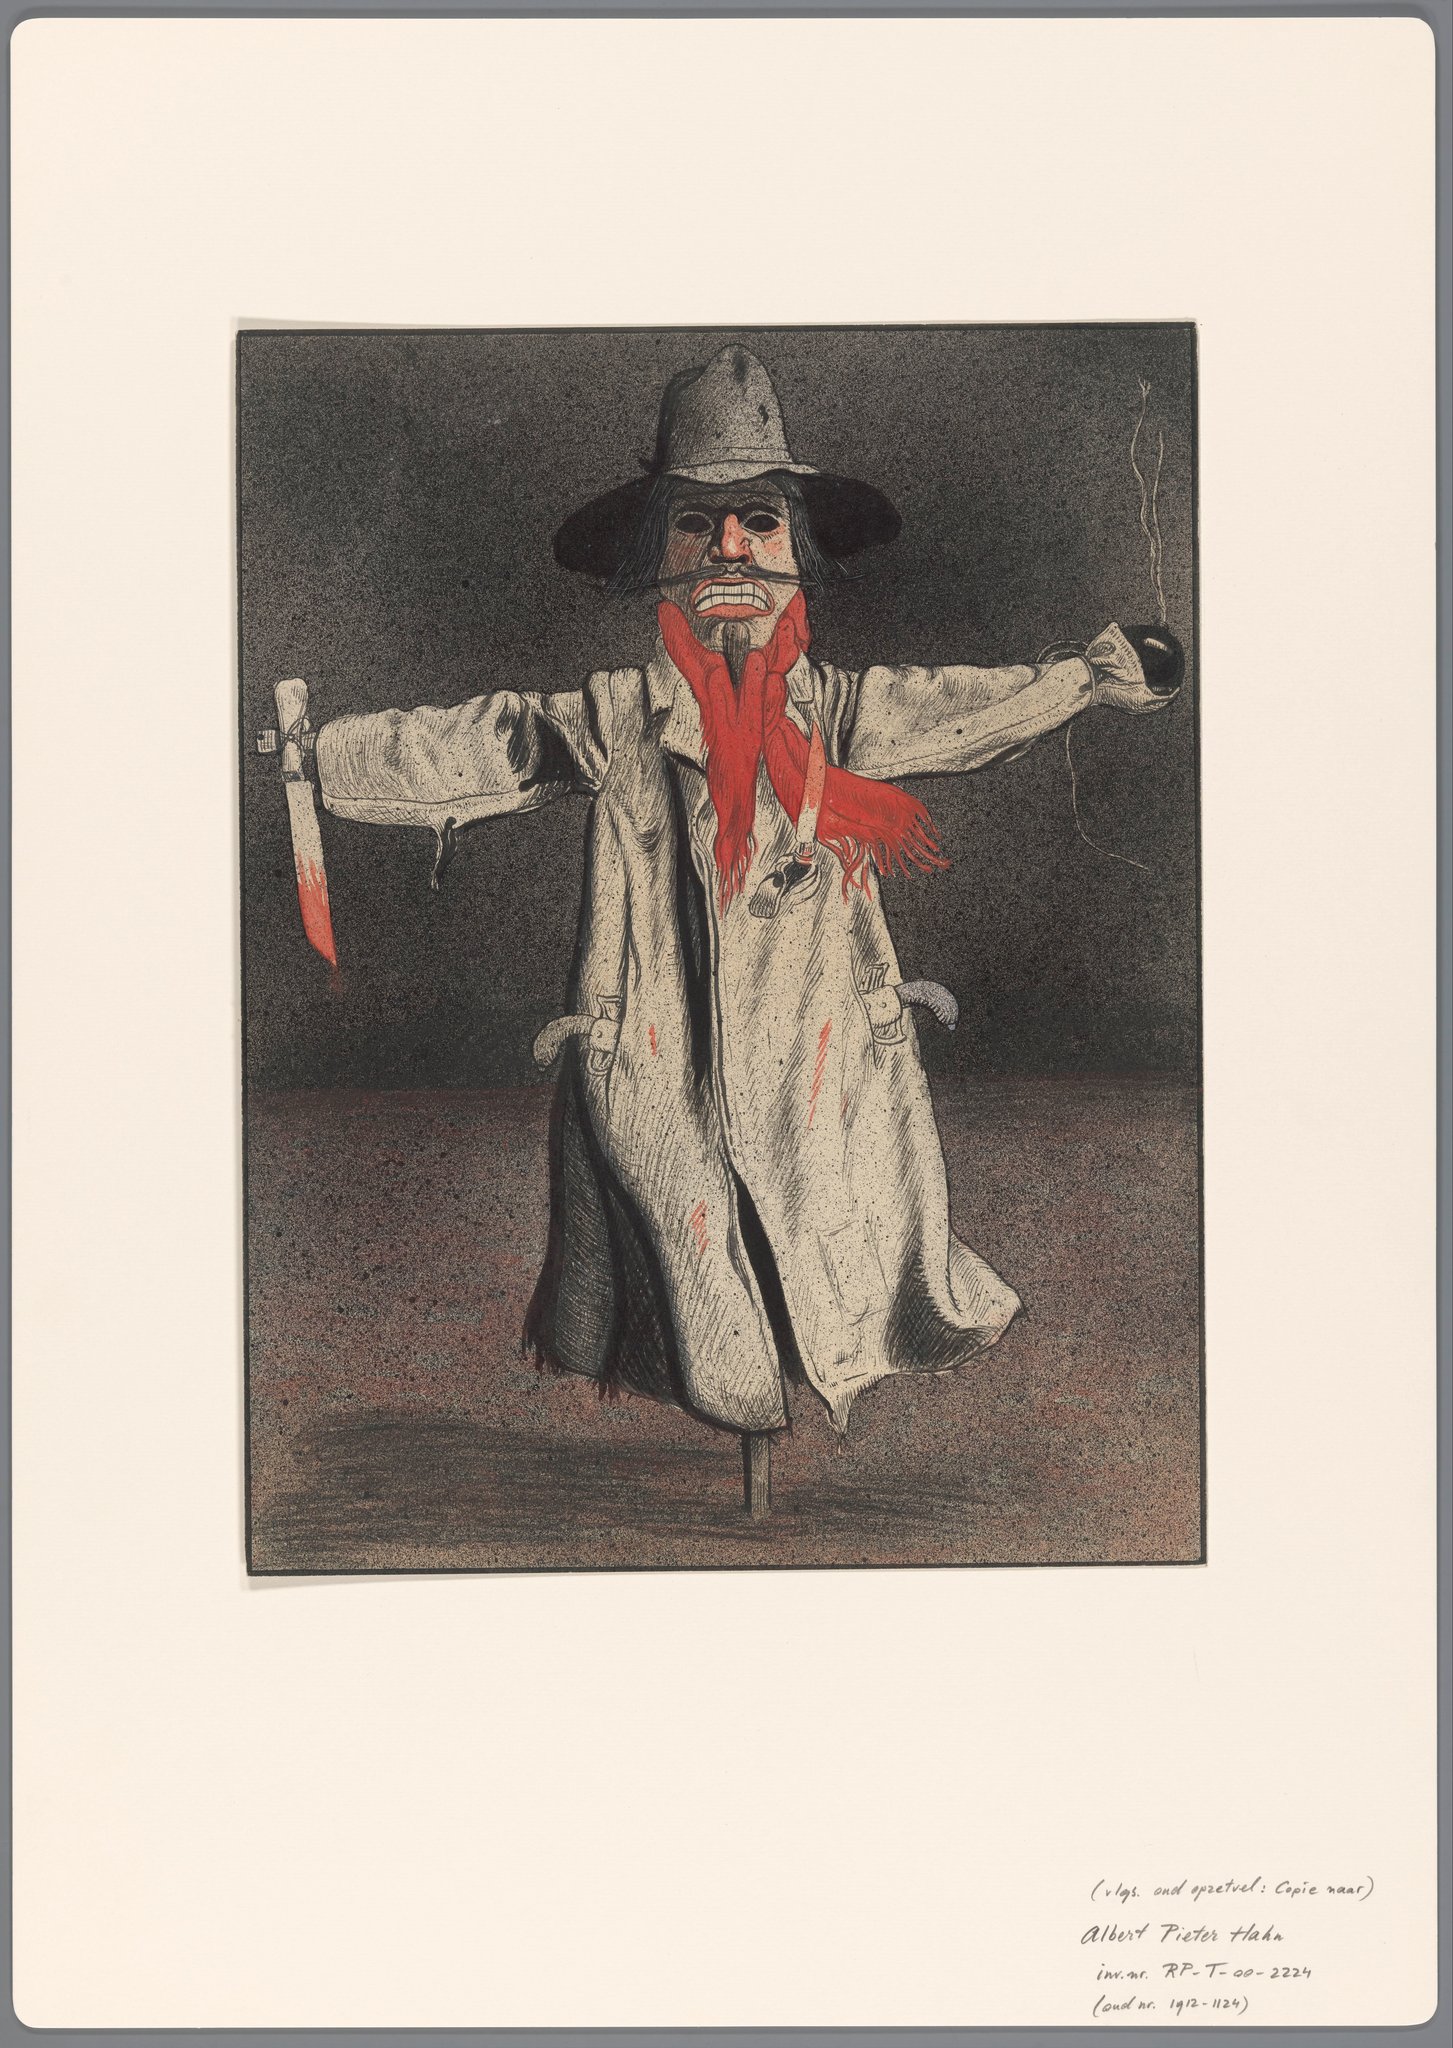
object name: drawing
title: Ontwerp voor een politieke spotprent: vogelverschrikker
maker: albert hahn (i)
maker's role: draughtsman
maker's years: 1877-1918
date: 1904-1905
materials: cardboard, chalk, ink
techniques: brush, pen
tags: the hague, abraham kuyper, scarecrow, political caricatures and satires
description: Ontwerp voor de prentserie 'Onder zwart regime' (1905).